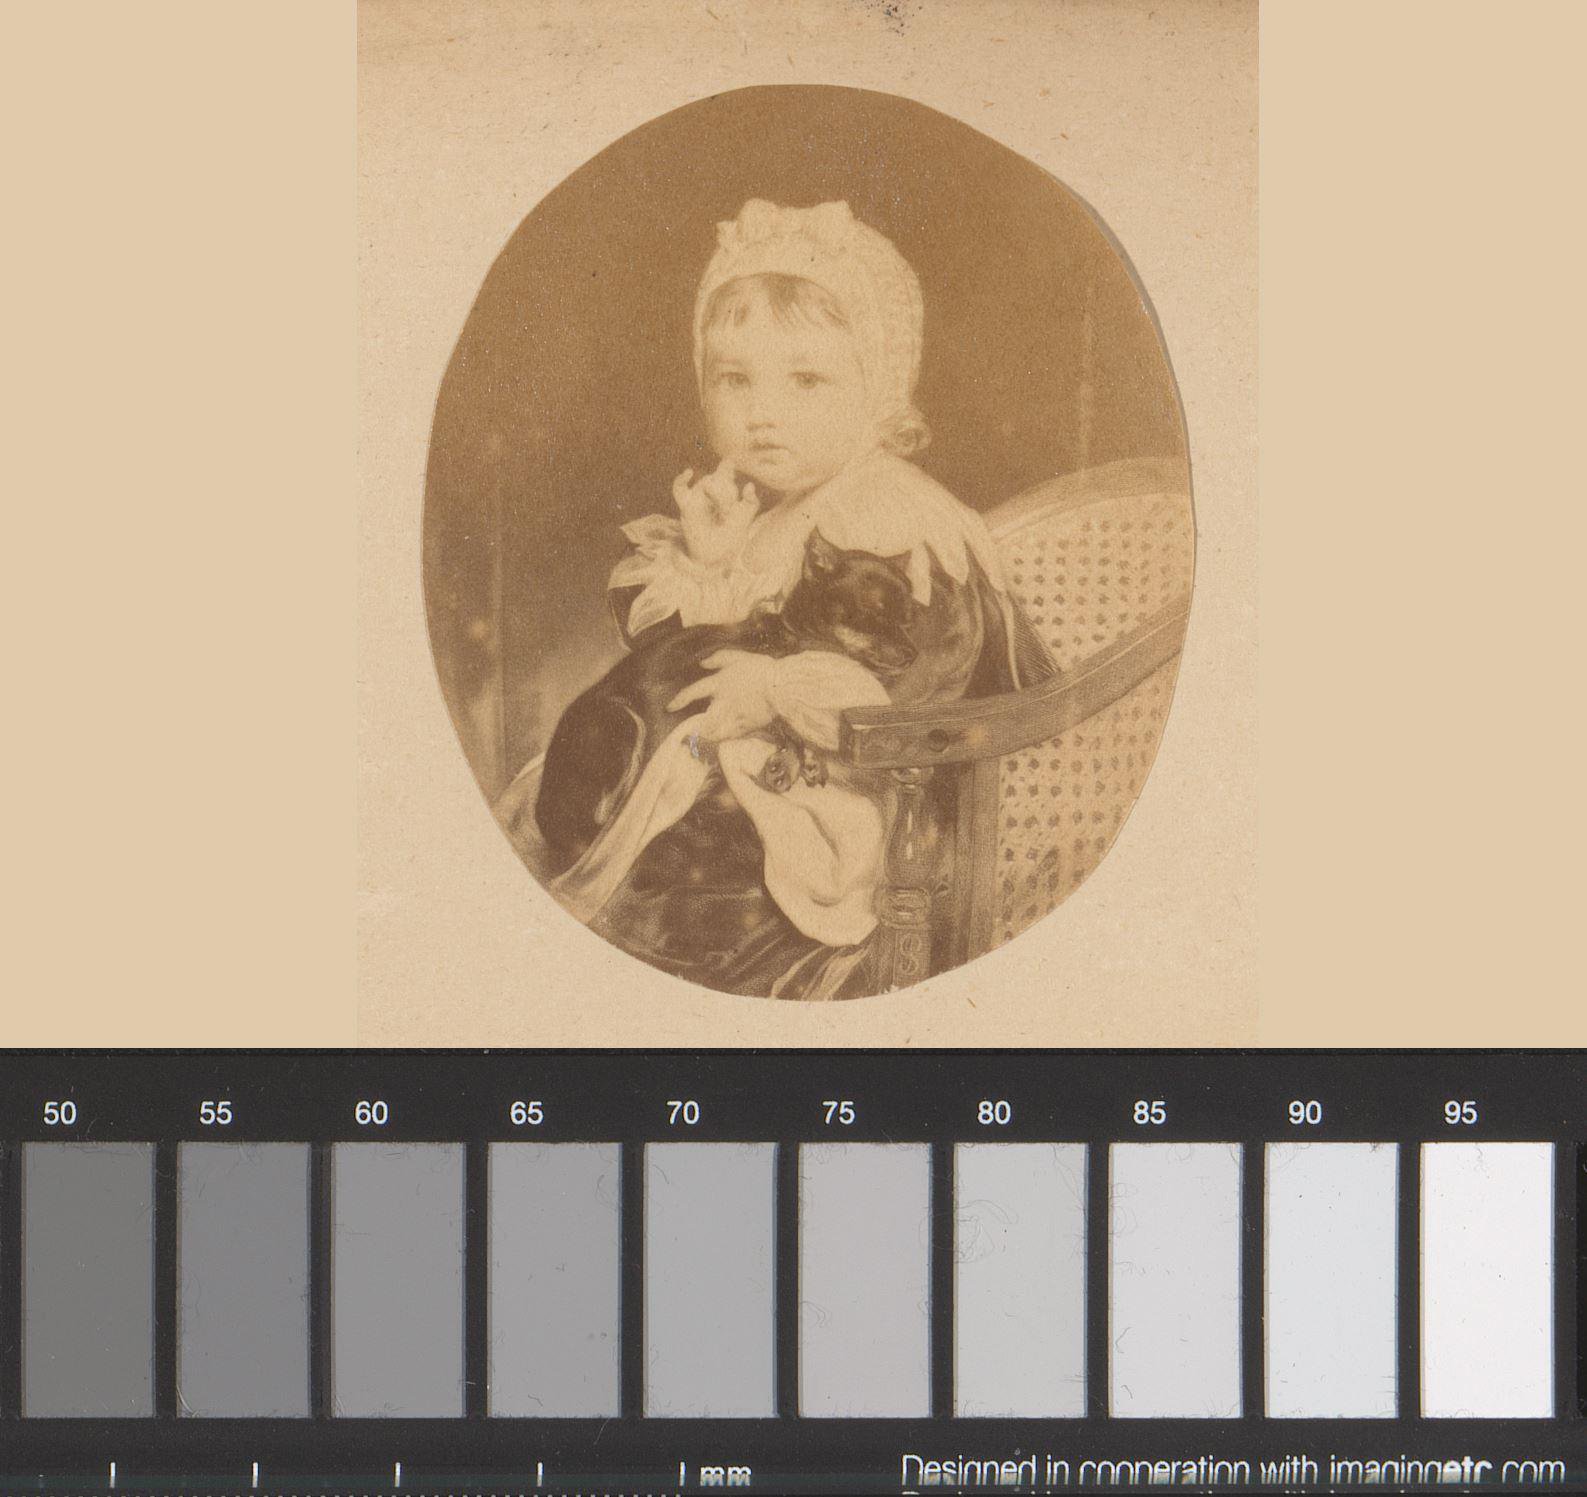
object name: photograph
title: Fotoreproductie van een geschilderd portret van een meisje met hond op schoot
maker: Anonymous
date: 1875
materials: paper, photographic support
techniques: albumen print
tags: girl (child between toddler and youth), dog